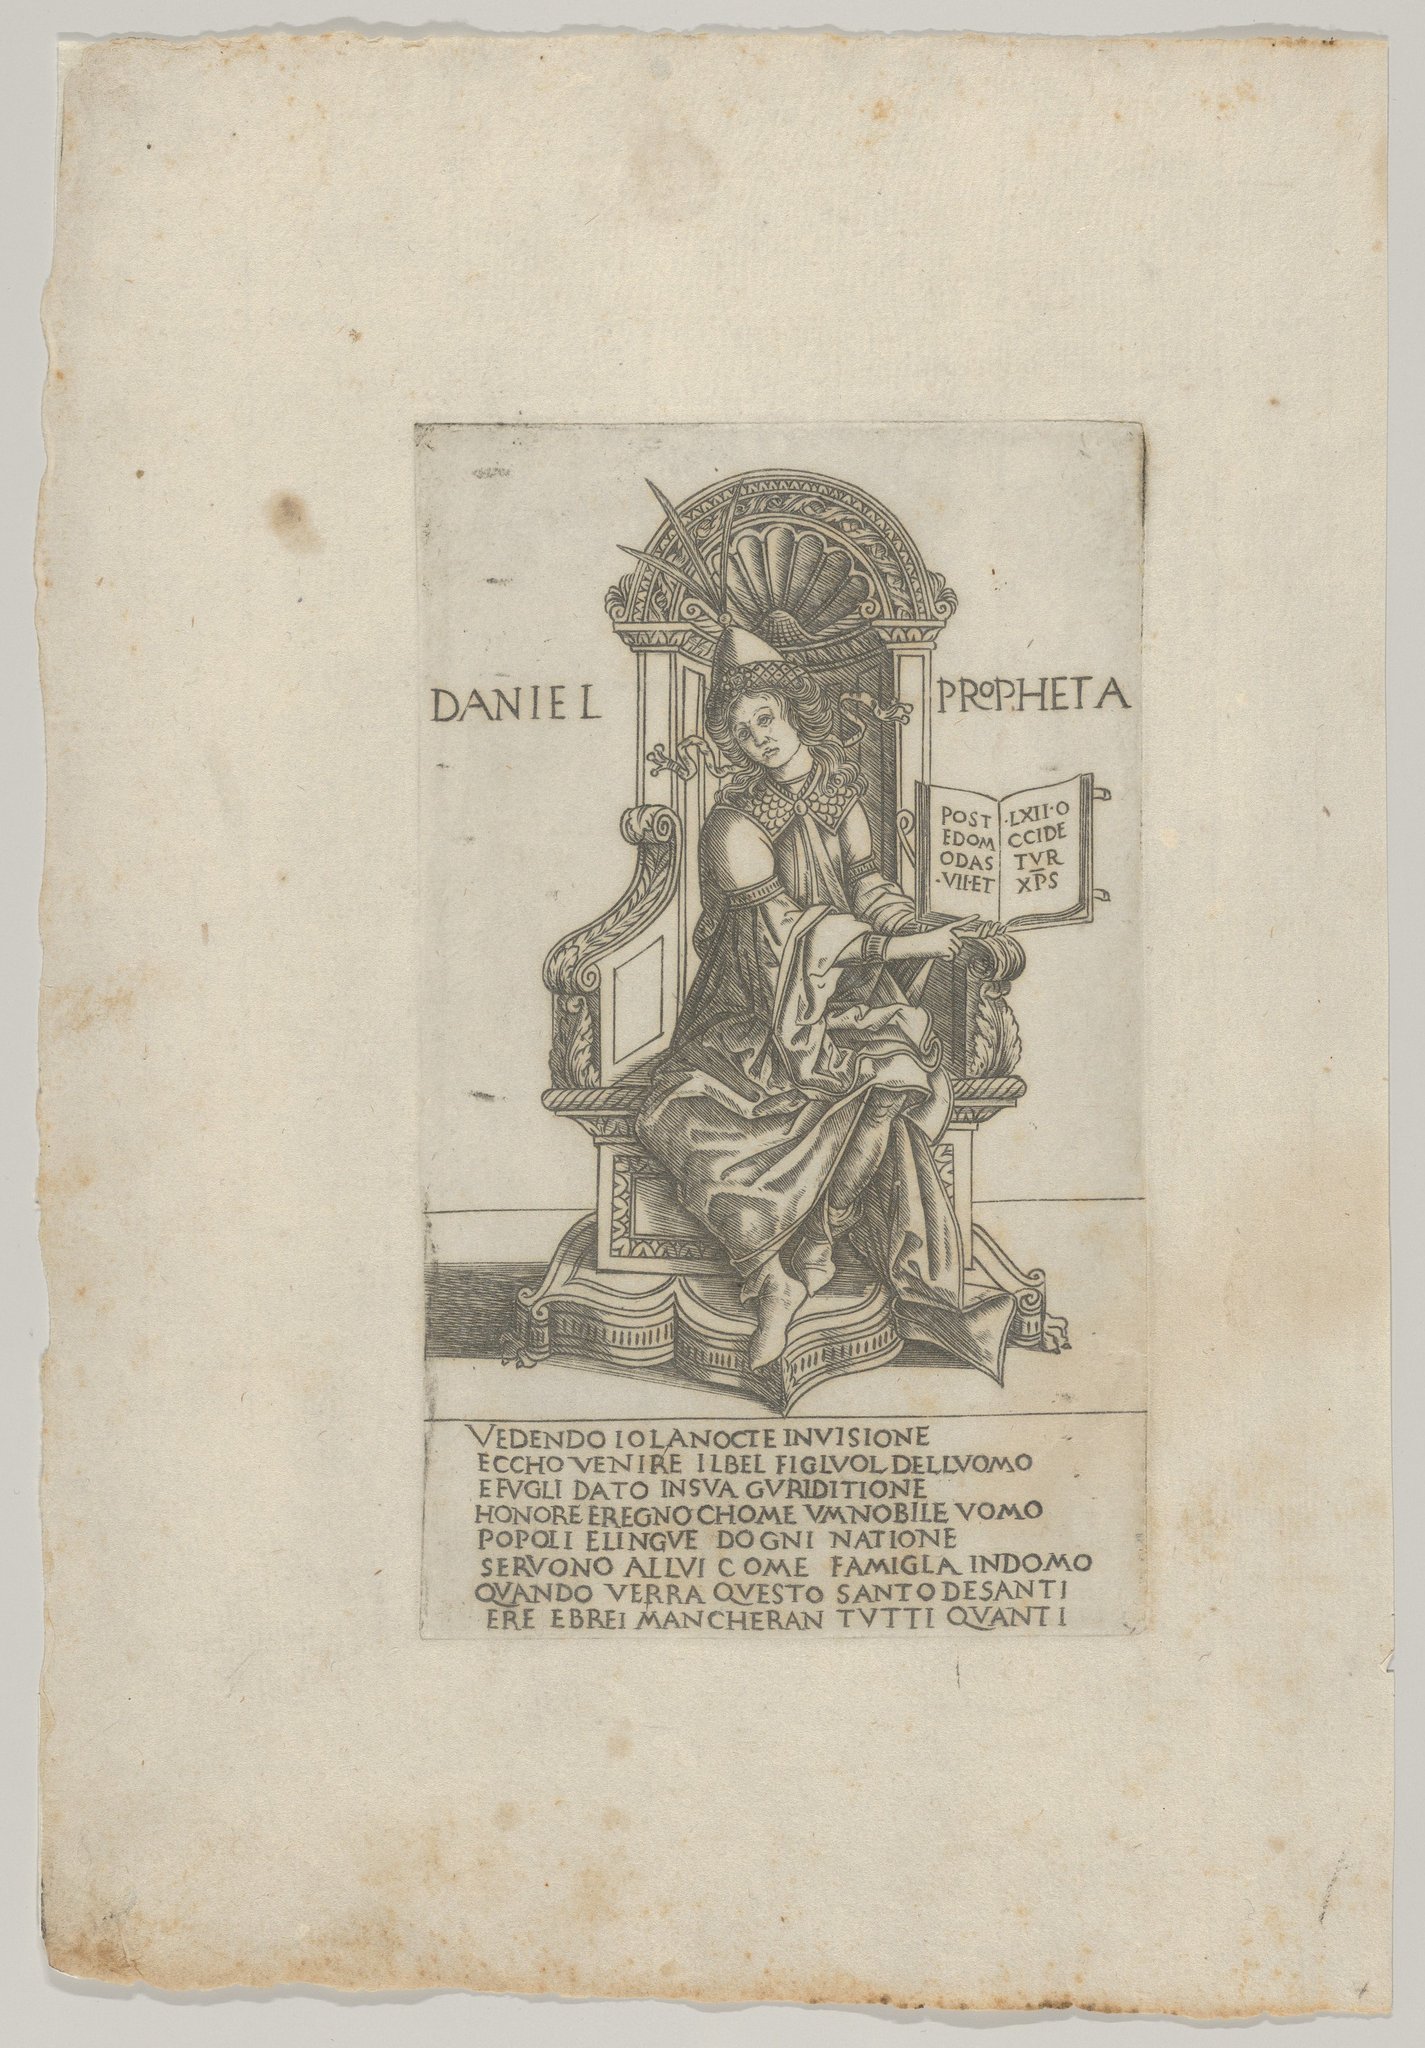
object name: print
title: The Prophet Daniel, from "Prophets and Sibyls"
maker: francesco rosselli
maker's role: artist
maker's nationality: italian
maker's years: 1448-1527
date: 1480-1490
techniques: engraving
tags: books,women